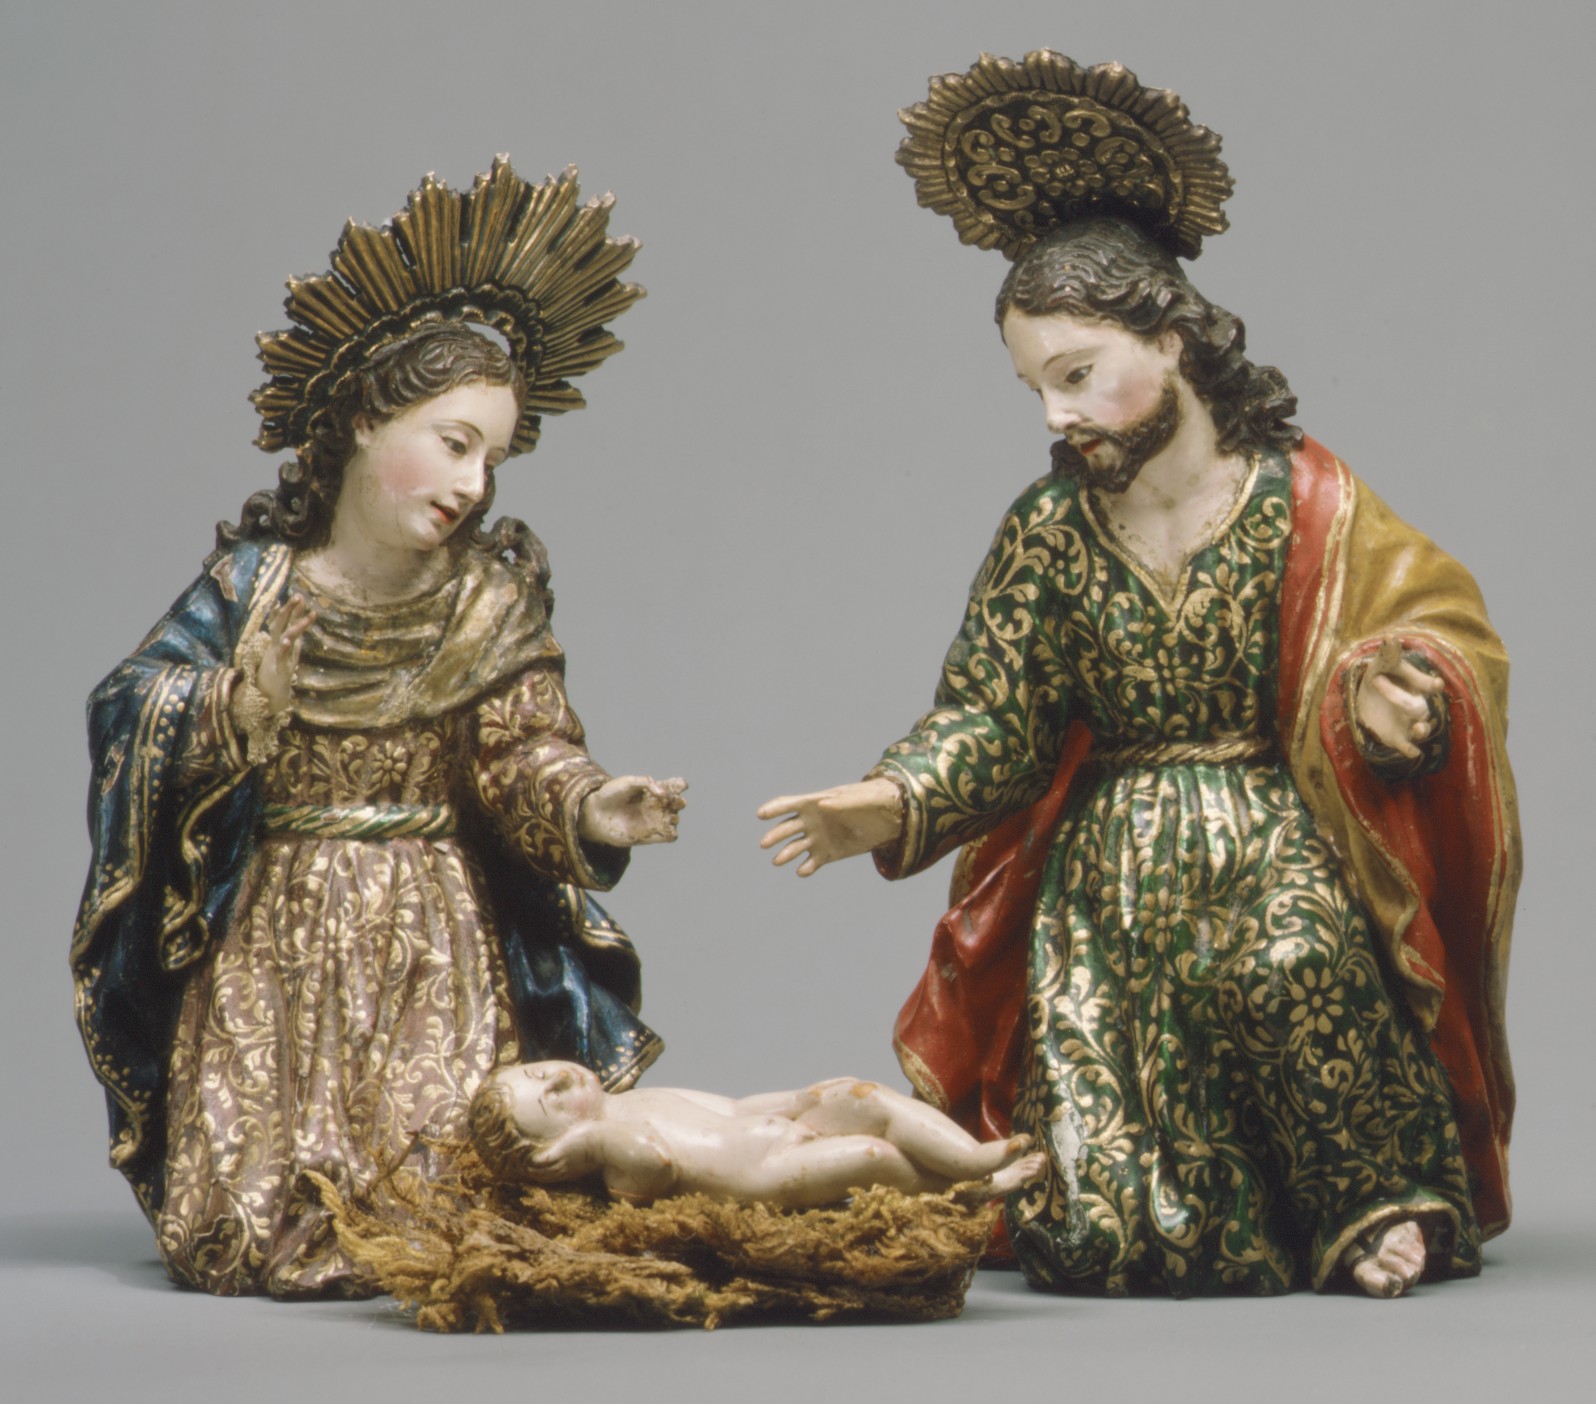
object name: statuette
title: Mary (from a nativity)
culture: ecuadorian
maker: caspicara (manuel chil)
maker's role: former attribution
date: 1701-1800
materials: glass, metal, wood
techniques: gilding, polychrome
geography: ecuador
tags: virgin mary